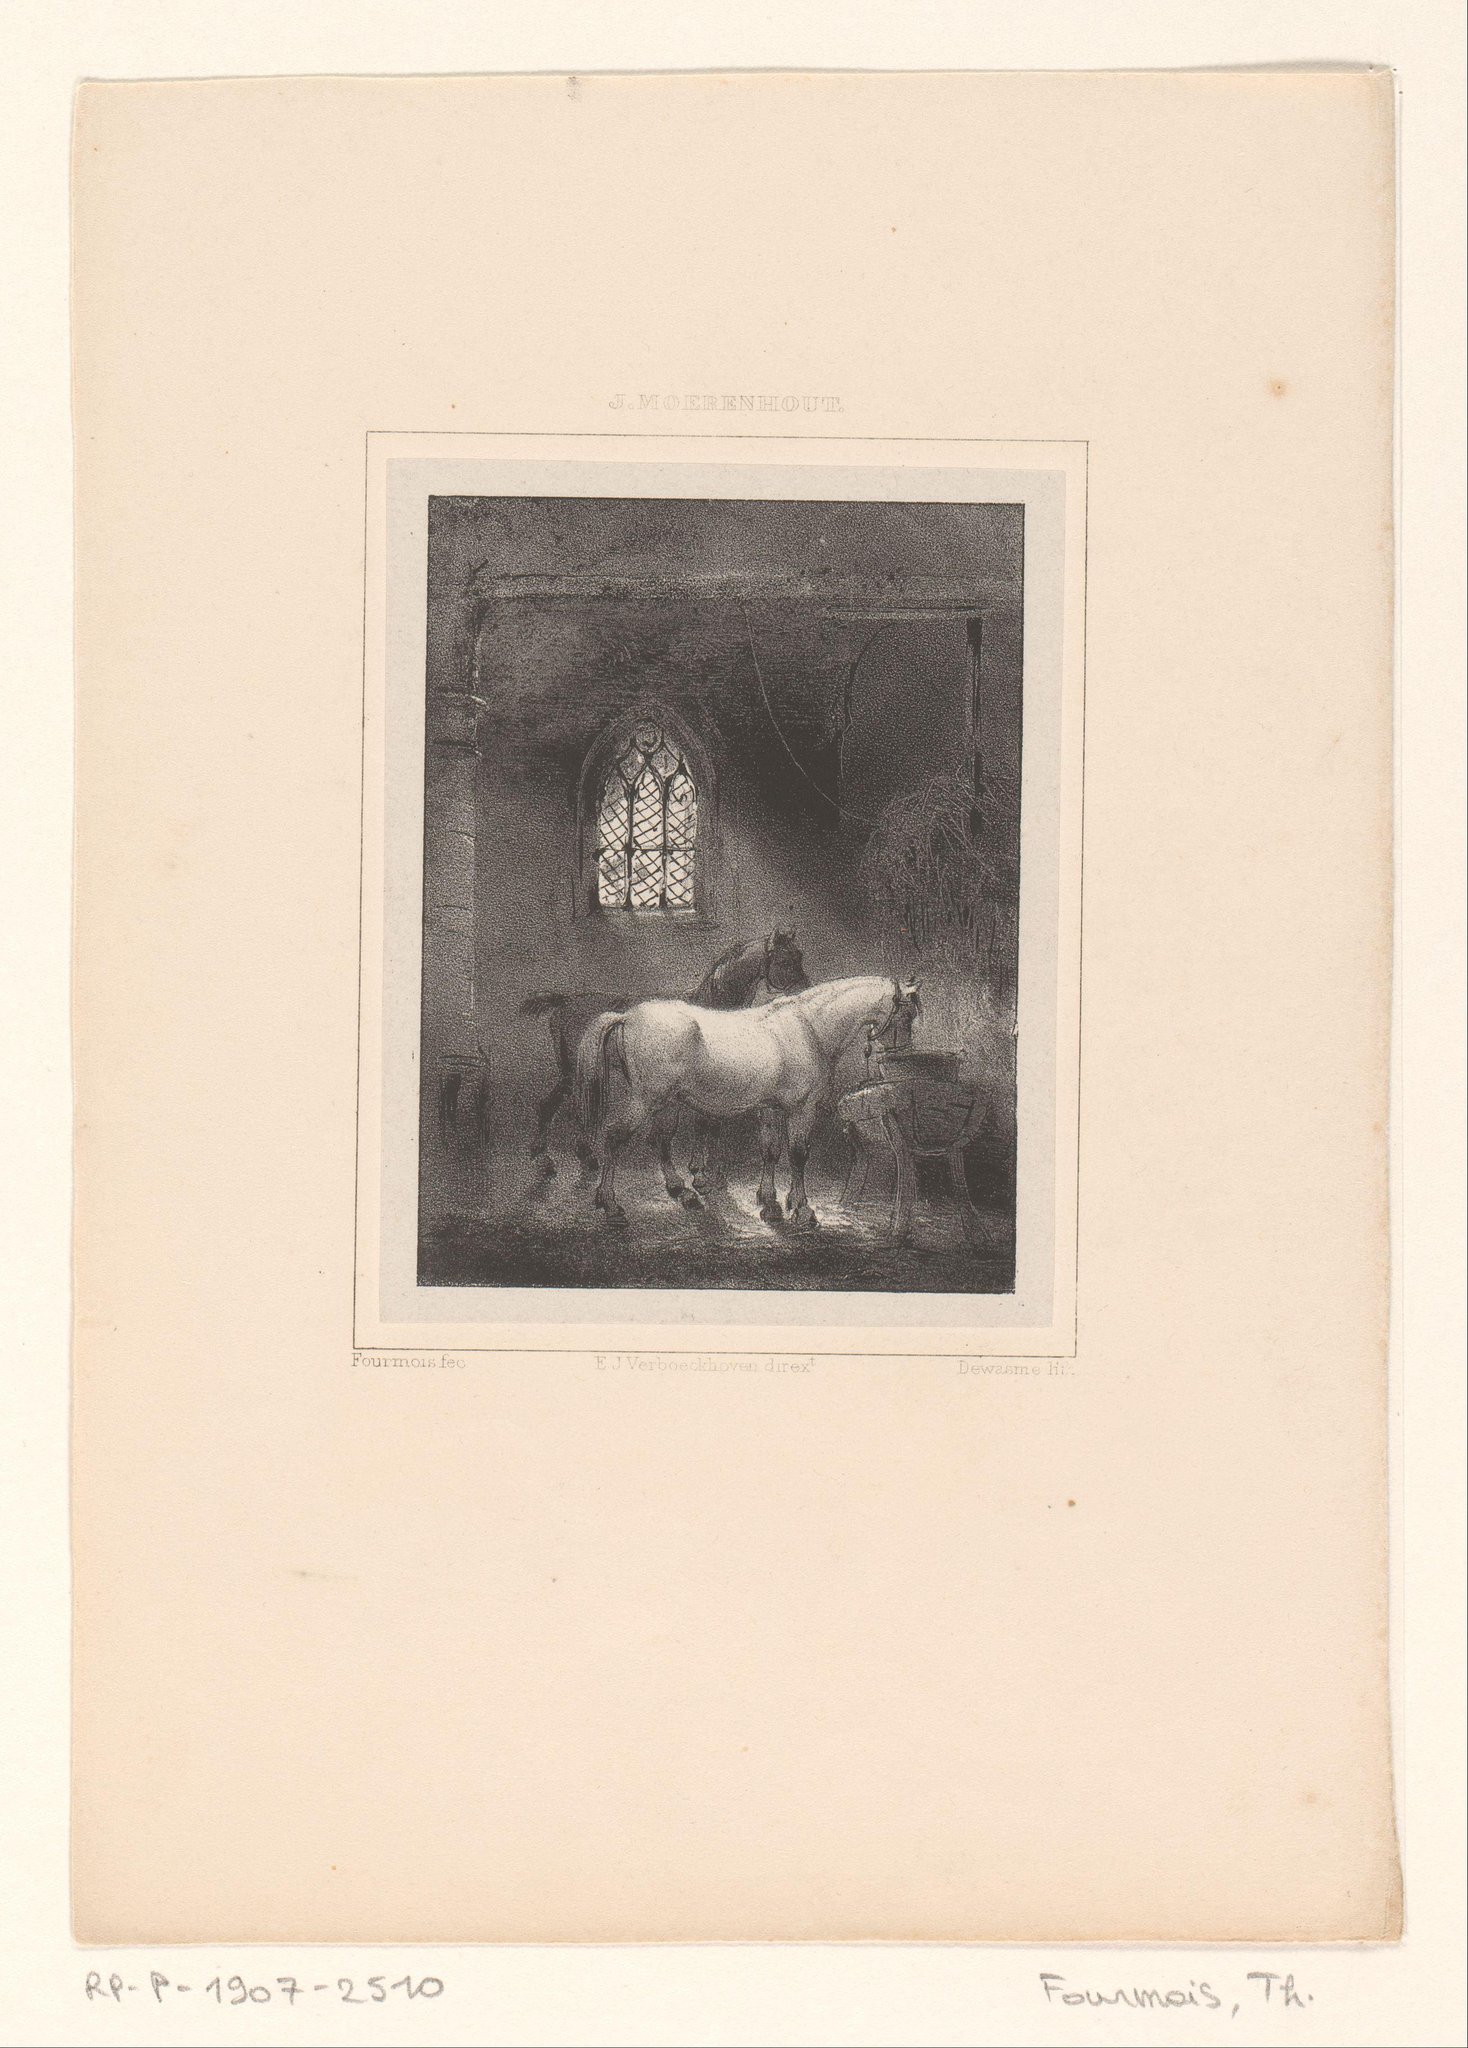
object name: print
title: J. Moerenhout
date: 1824-1827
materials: paper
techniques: lithograph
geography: brussels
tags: horse, stall, stable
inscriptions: collector's mark: Lugt 2228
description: Prent maakt waarschijnlijk deel uit van een serie met taferelen naar andere kunstenaars. Over deze serie is verder niets bekend.